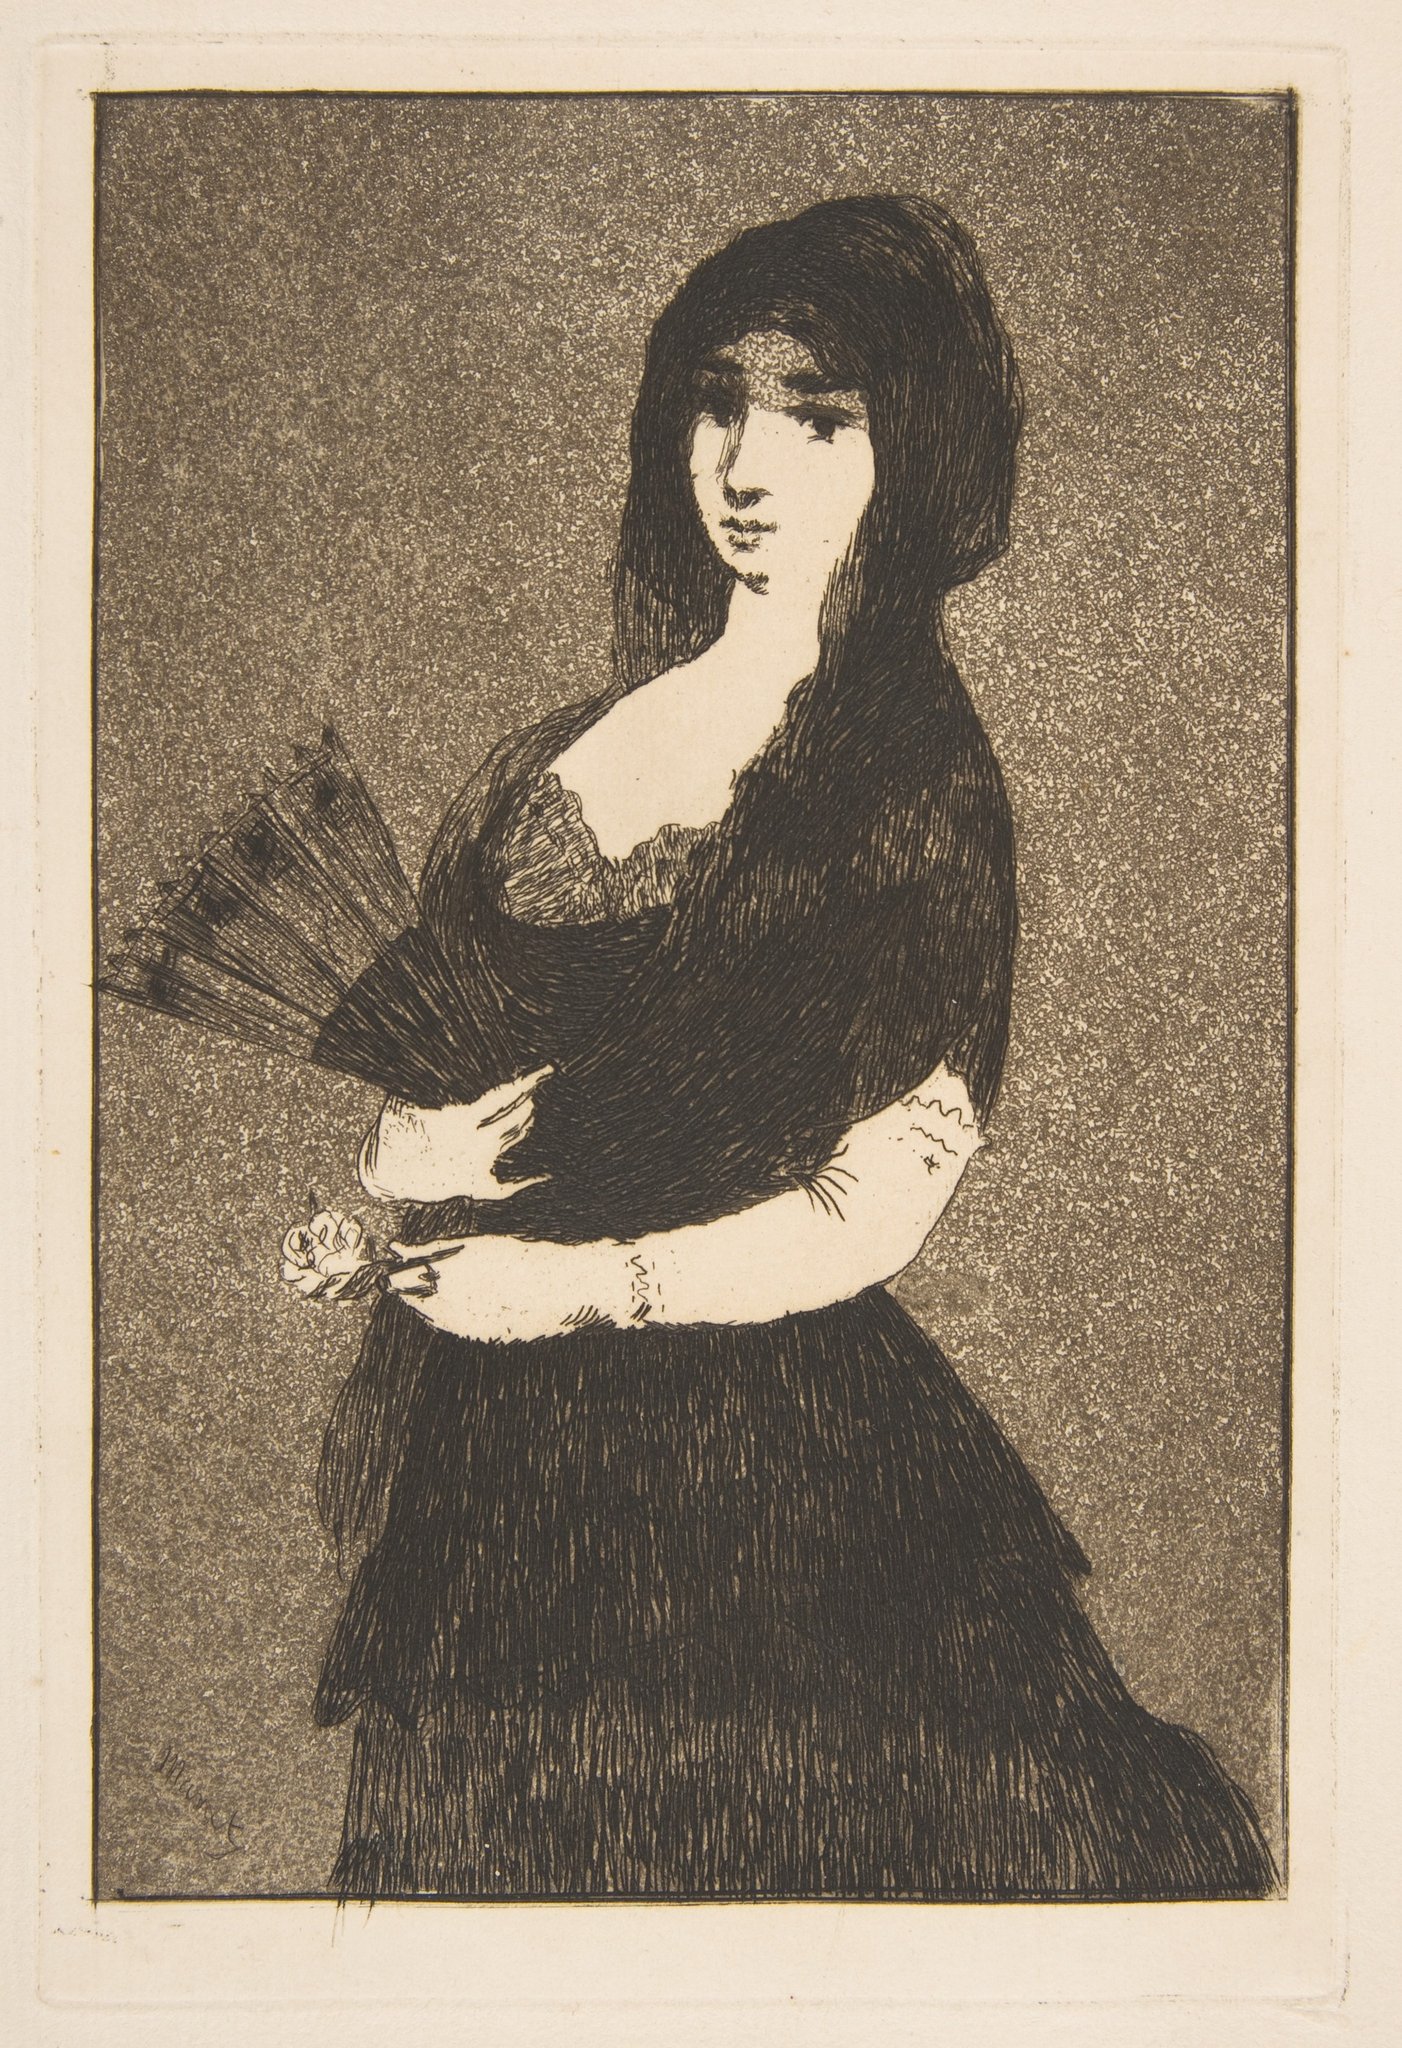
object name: print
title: Exotic Flower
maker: édouard manet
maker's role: artist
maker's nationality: french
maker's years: 1832-1883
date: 1868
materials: paper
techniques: aquatint, etching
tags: fans,women